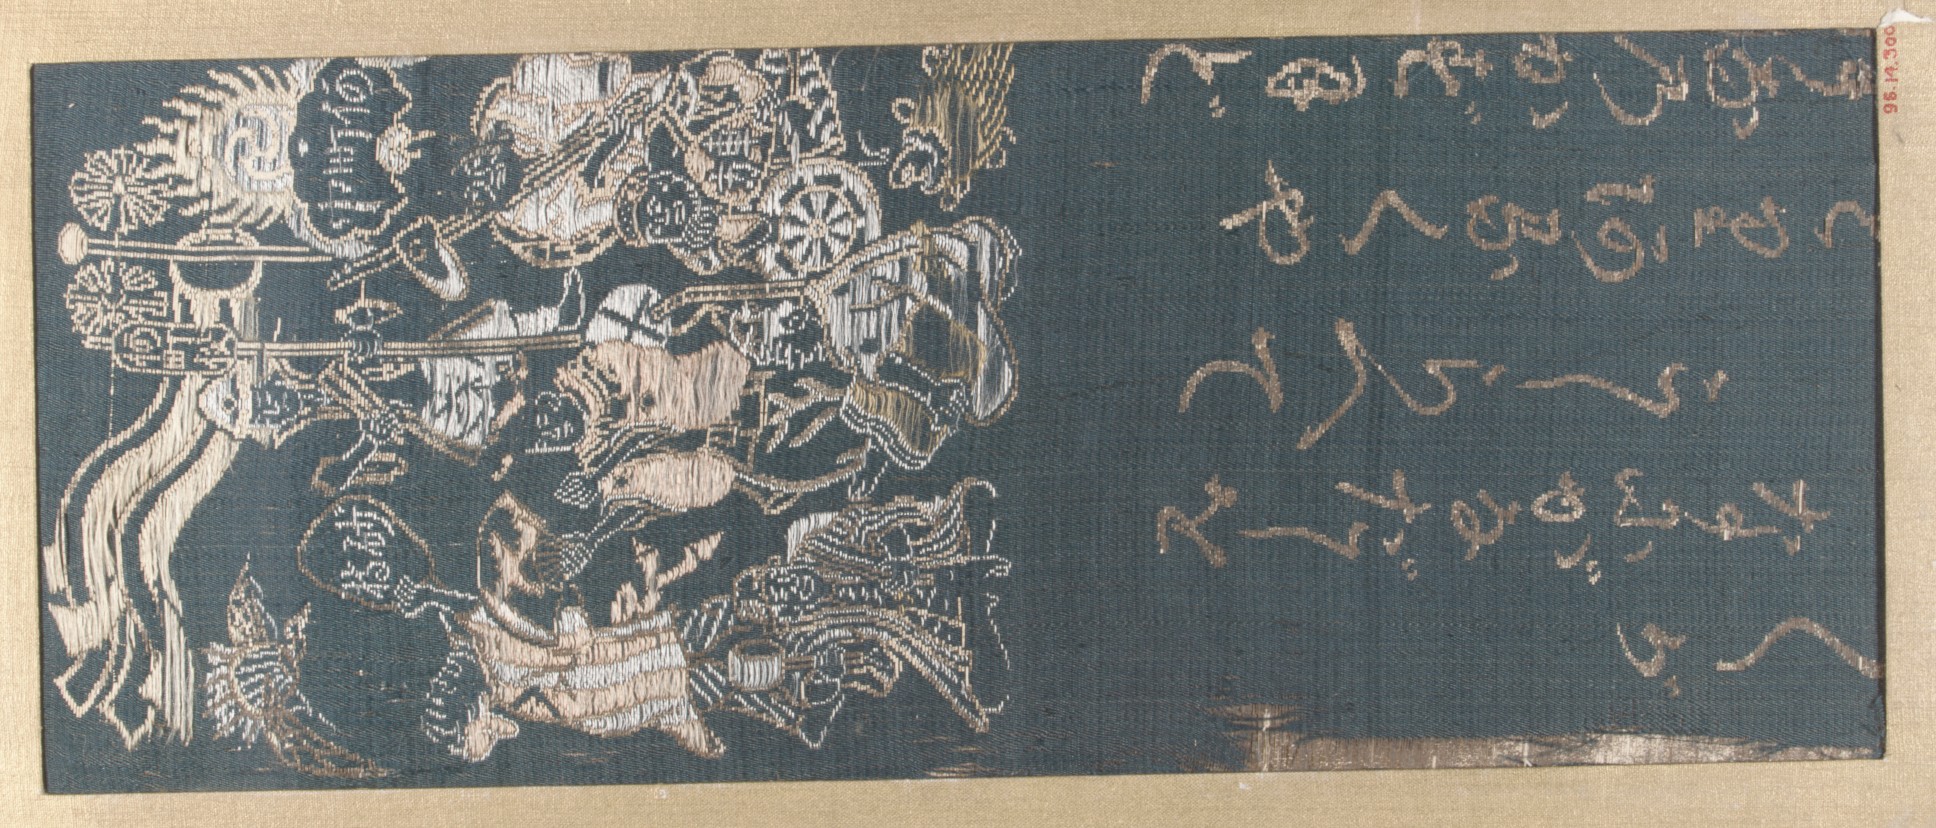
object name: piece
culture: japanese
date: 1701-1900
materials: silk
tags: human figures